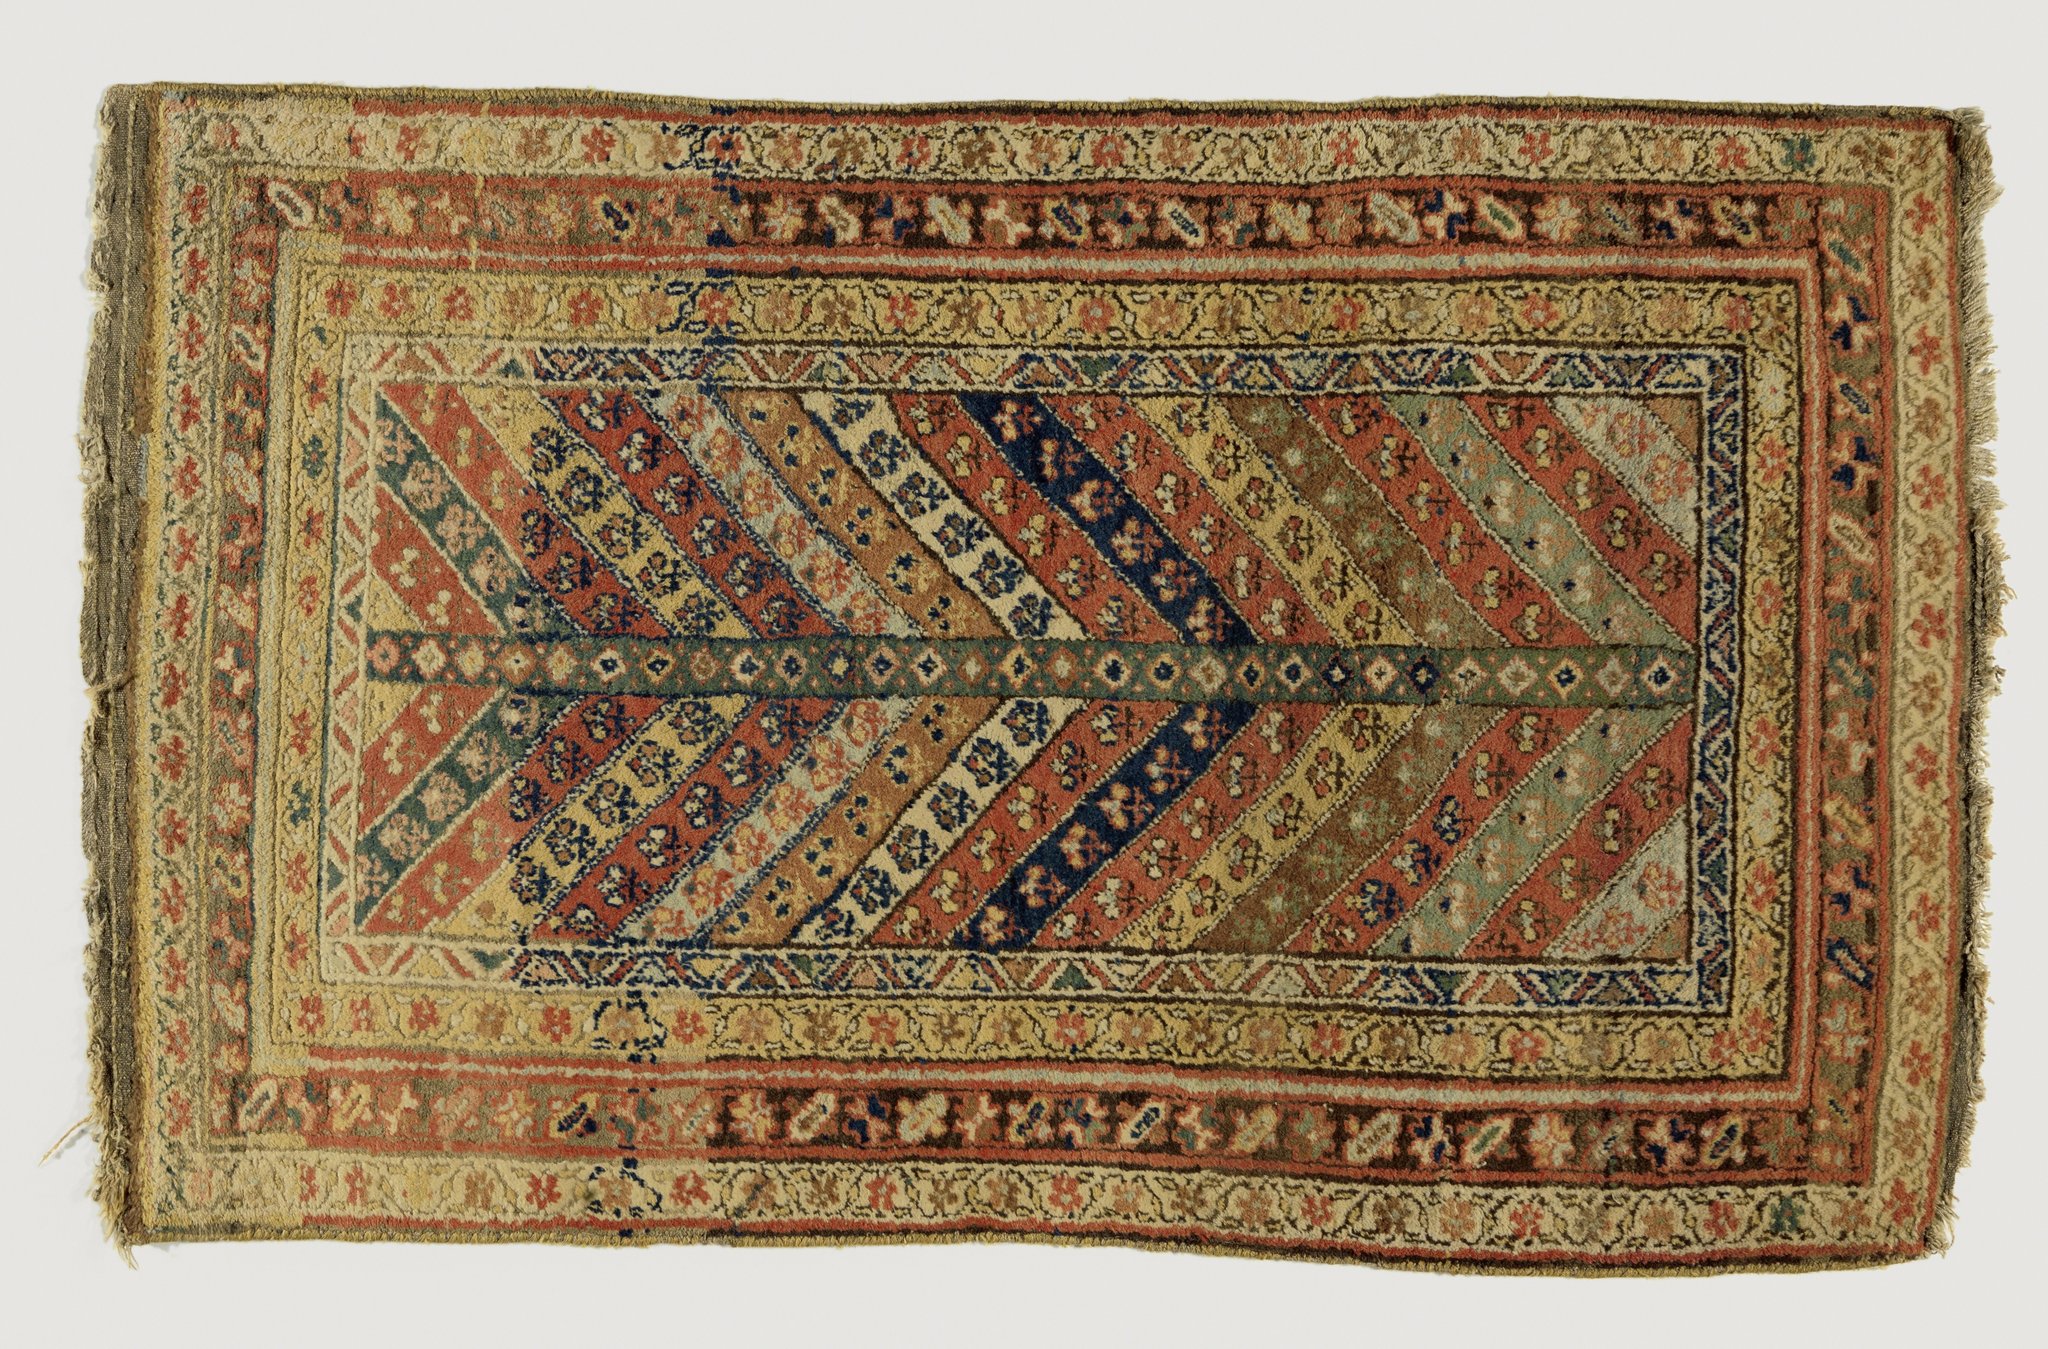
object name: tapijt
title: Tapijt, zogenaamd strepenkleed. In het middenveld V-vormige strepen met bloemen en een verticale streep met ruiten. Viervoudige rand met bloemenranken.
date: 1800-1900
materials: wool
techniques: ghiordes knot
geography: kurdistan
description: Oosters tapijt, strepenkleed. In het middenveld v-vormige strepen met bloemen en een verticale streep met ruiten. Viervoudige rand met bloemenranken. Bovenaan een geborduurde baard.